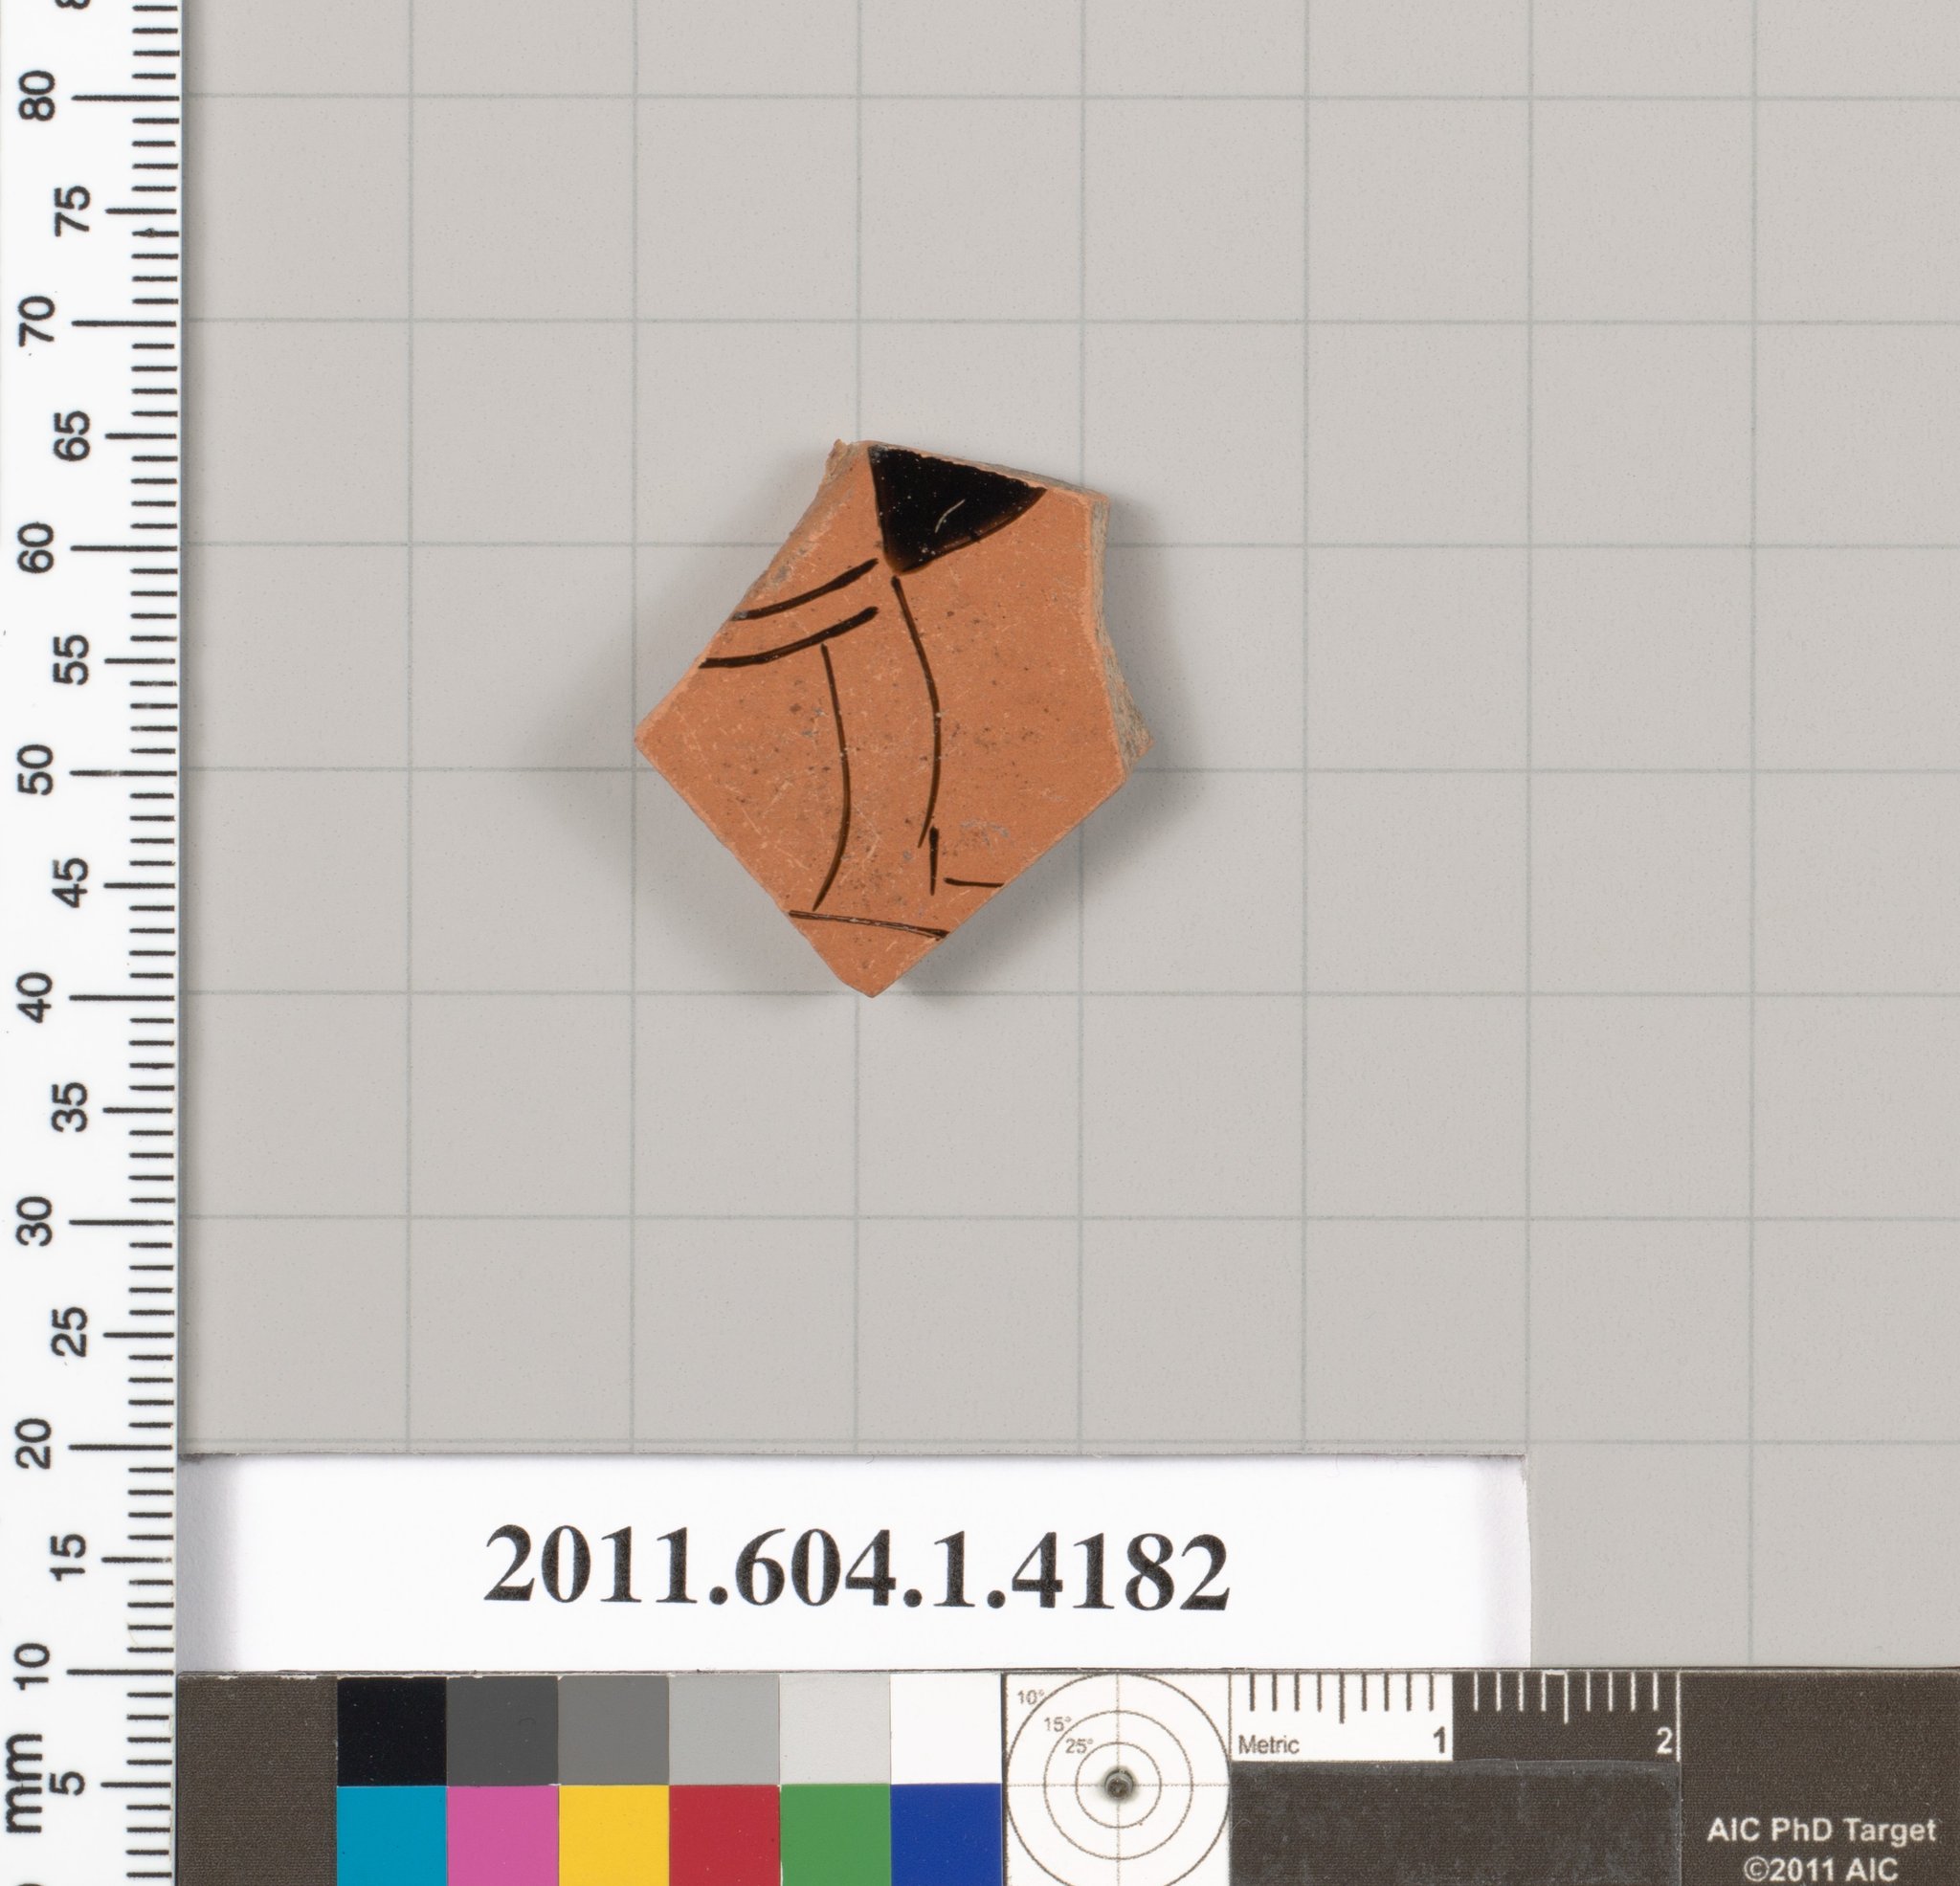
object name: kylix fragment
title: Terracotta fragment of a kylix (drinking cup)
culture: greek, attic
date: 500-480 BCE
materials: terracotta